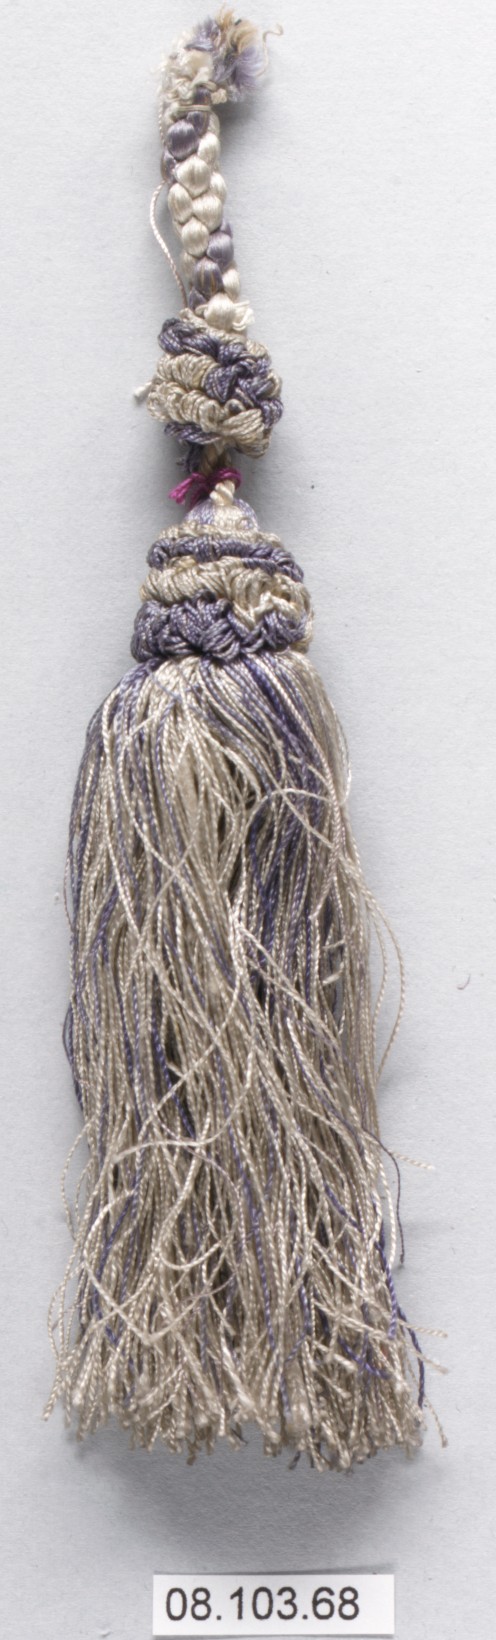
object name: tassel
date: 1801-1900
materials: silk